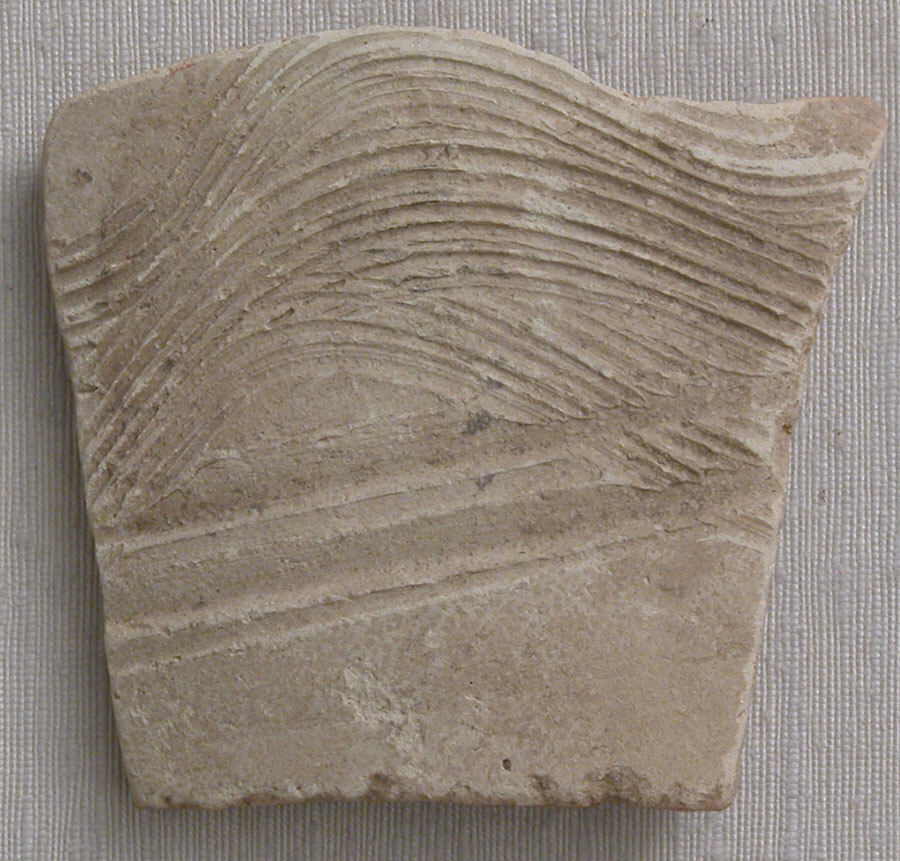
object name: fragment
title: Ceramic Fragment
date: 701-900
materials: earthenware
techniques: incising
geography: iraq